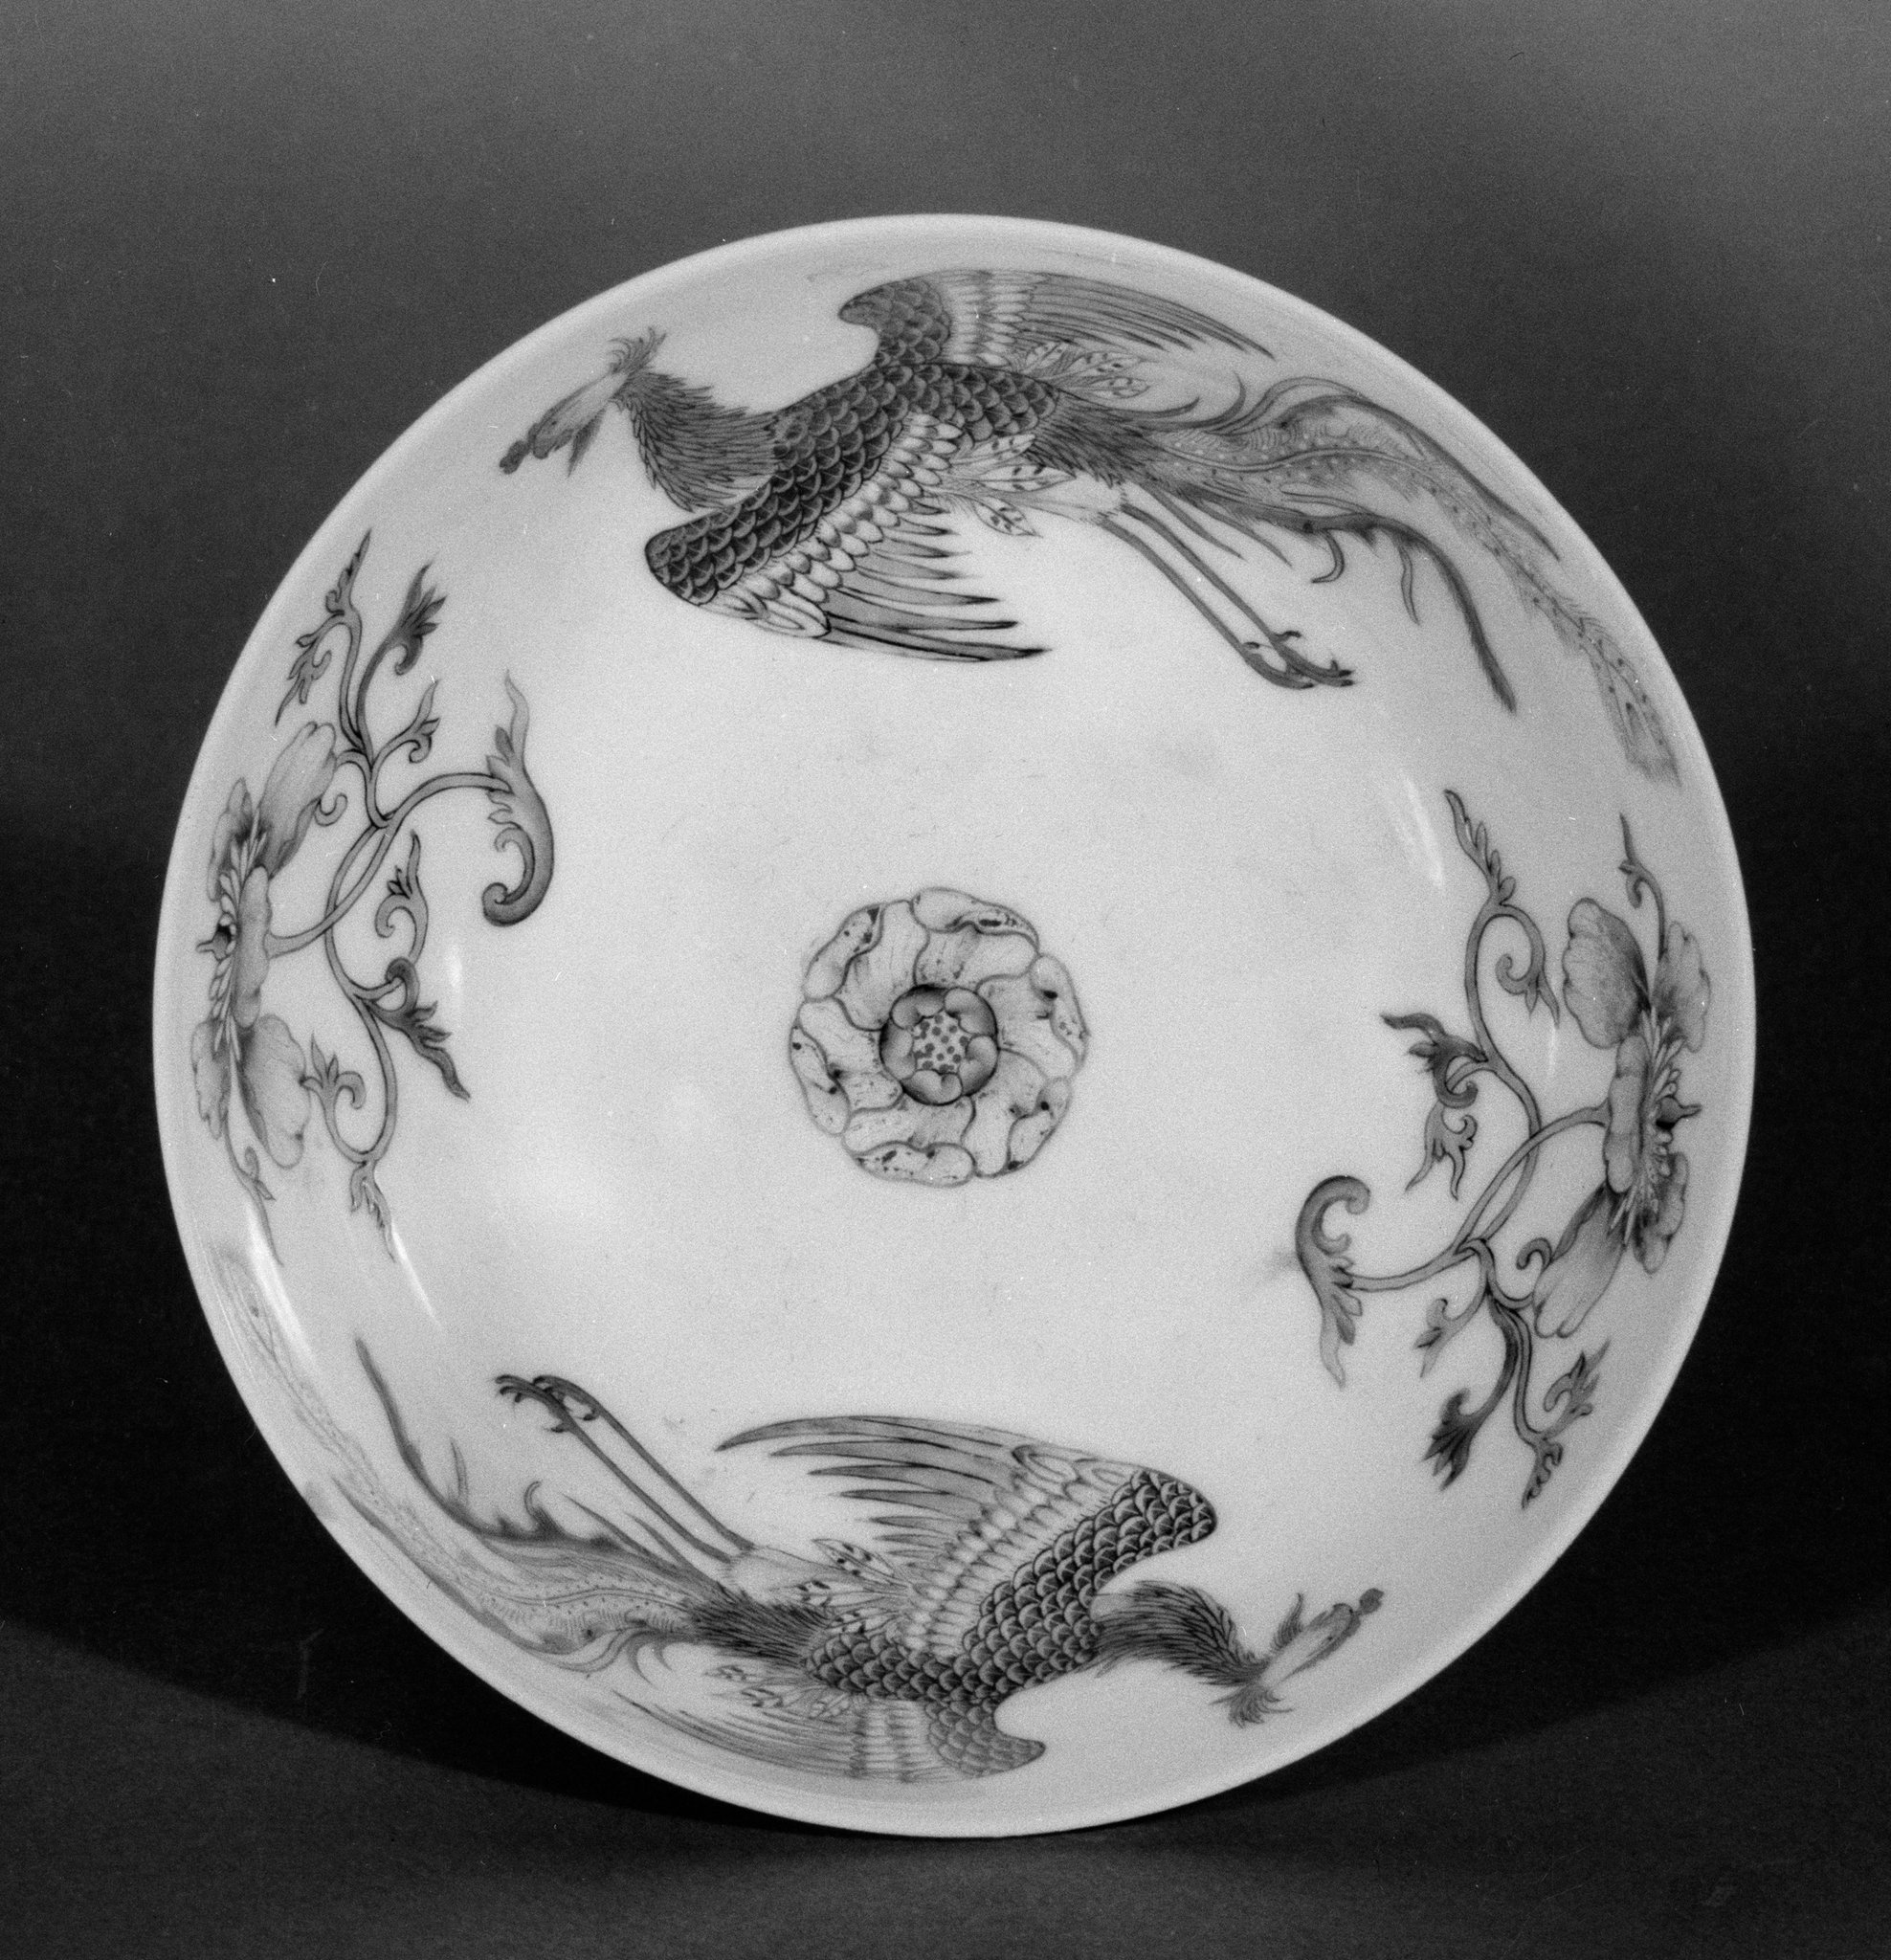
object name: bowl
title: Bowl with phoenixes (one of a pair)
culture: chinese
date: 1734-1766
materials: enamel, porcelain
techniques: overglaze, painting, polychrome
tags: birds,flowers